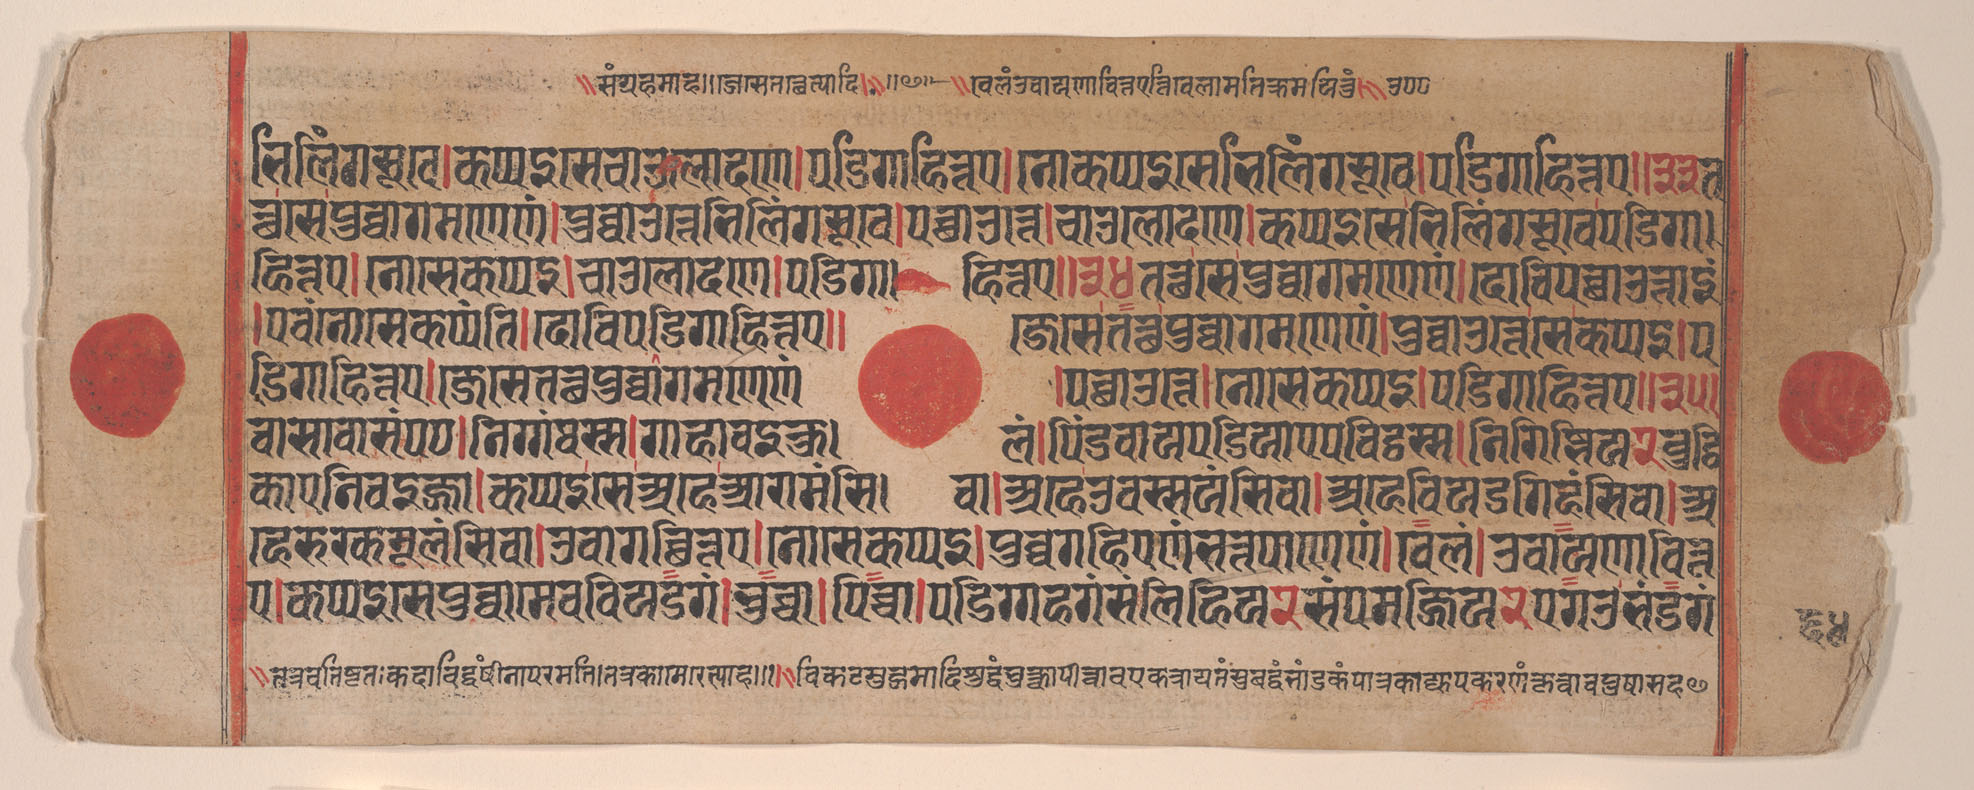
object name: folio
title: Leaf from a Kalpa Sutra (Jain Book of Rituals)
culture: indian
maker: bhadrabahu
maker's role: artist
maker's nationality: indian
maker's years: 356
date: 1401-1500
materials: gold, ink, paper, watercolor